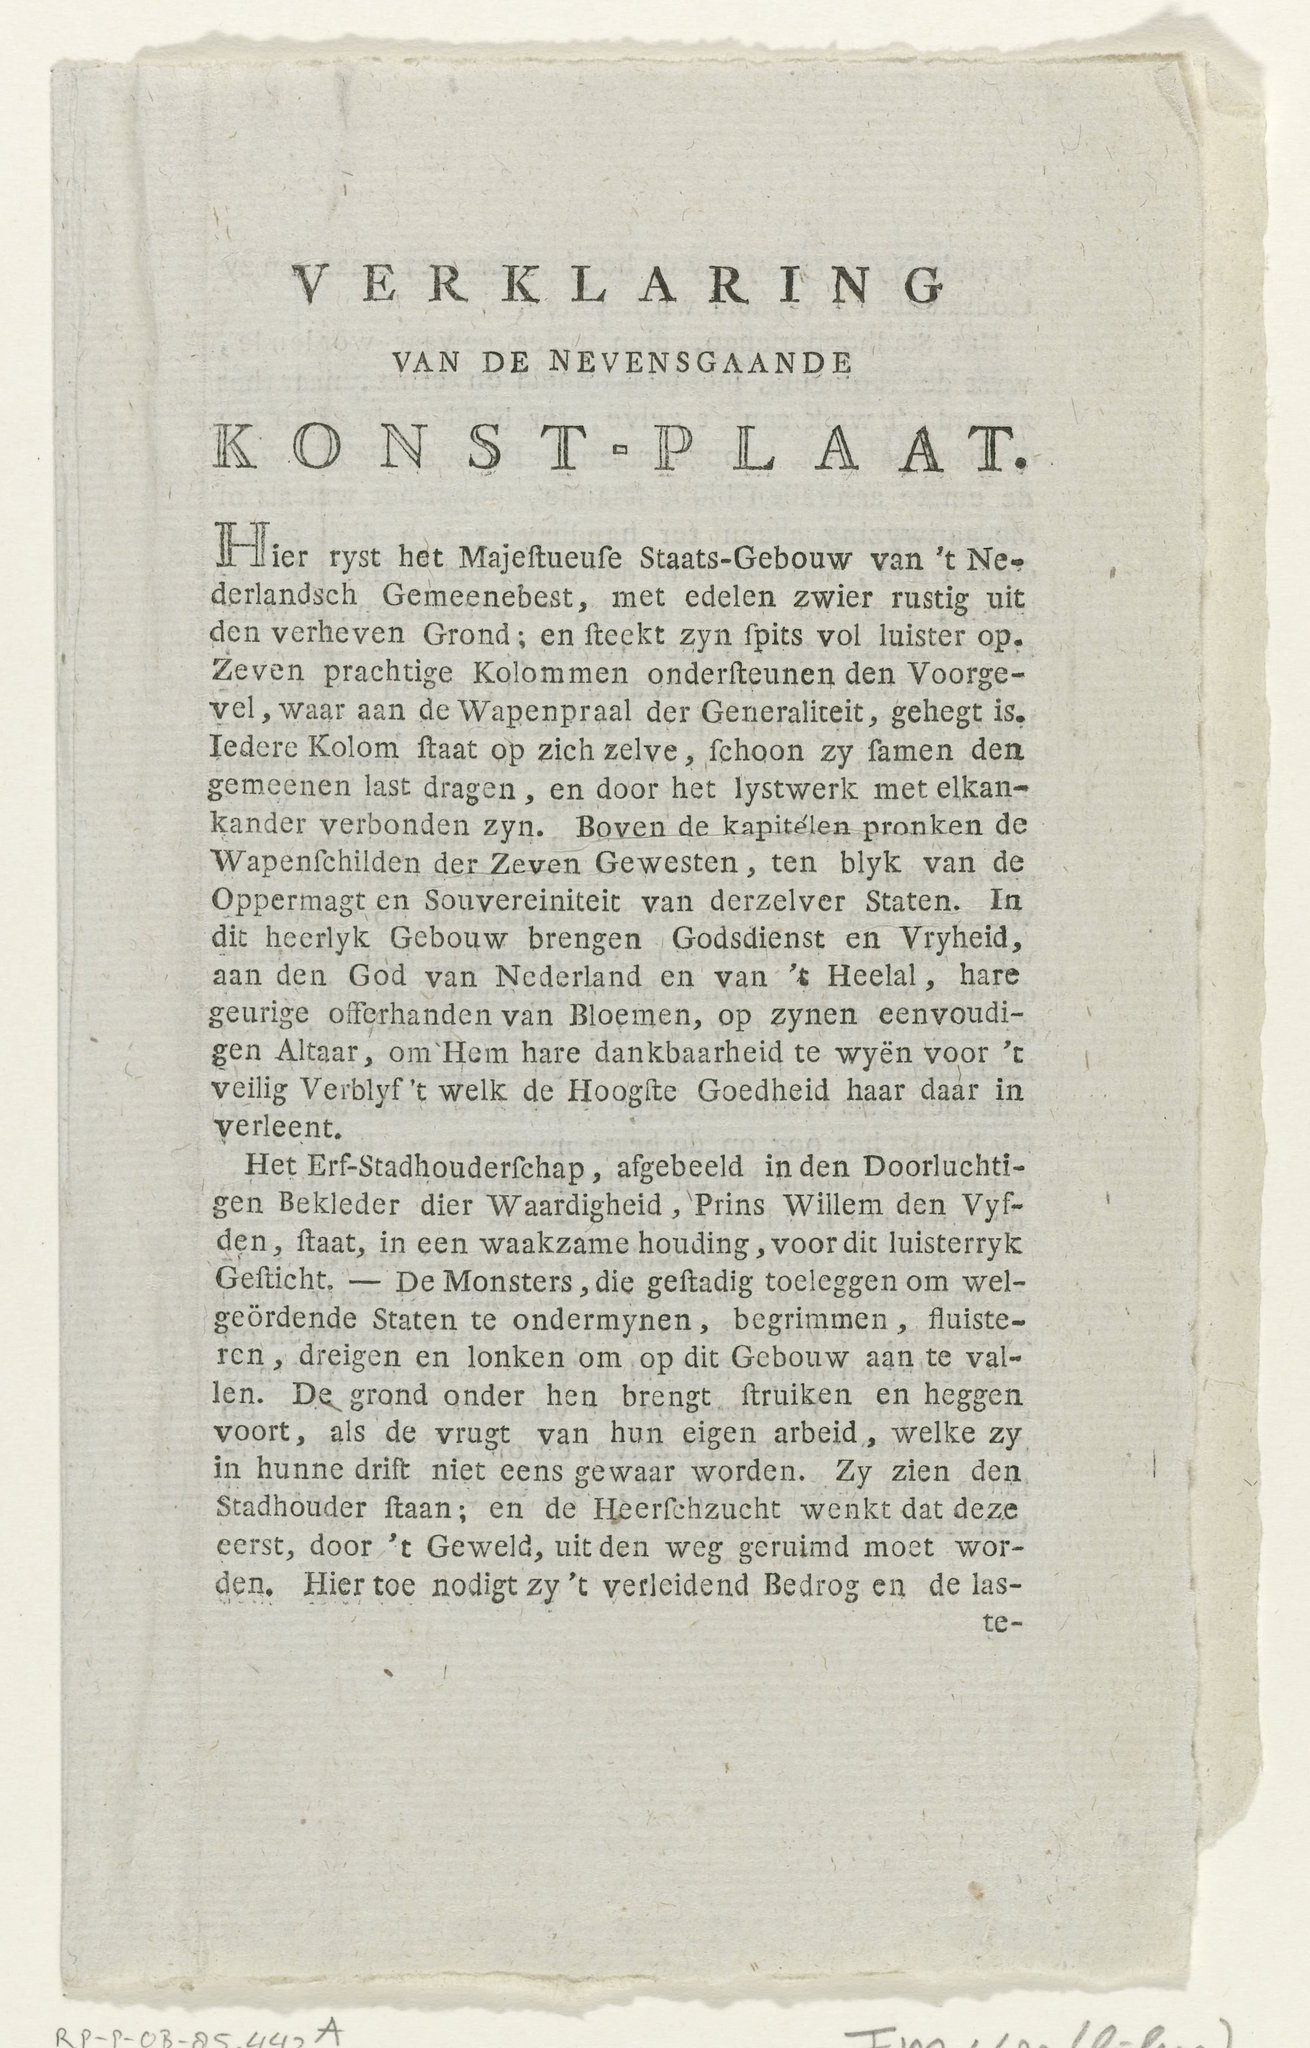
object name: text sheet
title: Bericht van Johannes Hofhout en Zoon, boekverkopers te Rotterdam. Aan de Heeren Intekenaren op den Katechismus van het Stadhouderschap / Verklaring van de nevensgaande Konst-Plaat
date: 1785-1786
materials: paper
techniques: letterpress printing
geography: rotterdam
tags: william v (prince of orange), patriots (1780-1795)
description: Tekstblad met een bericht van de uitgever over de publicatie van het boek Katechismus van het stadhouderschap, de prijzen van de los verkrijgbare titelplaat en een verklaring van deze plaat. Dubbelgevouwen blad bedrukt op alle zijden.